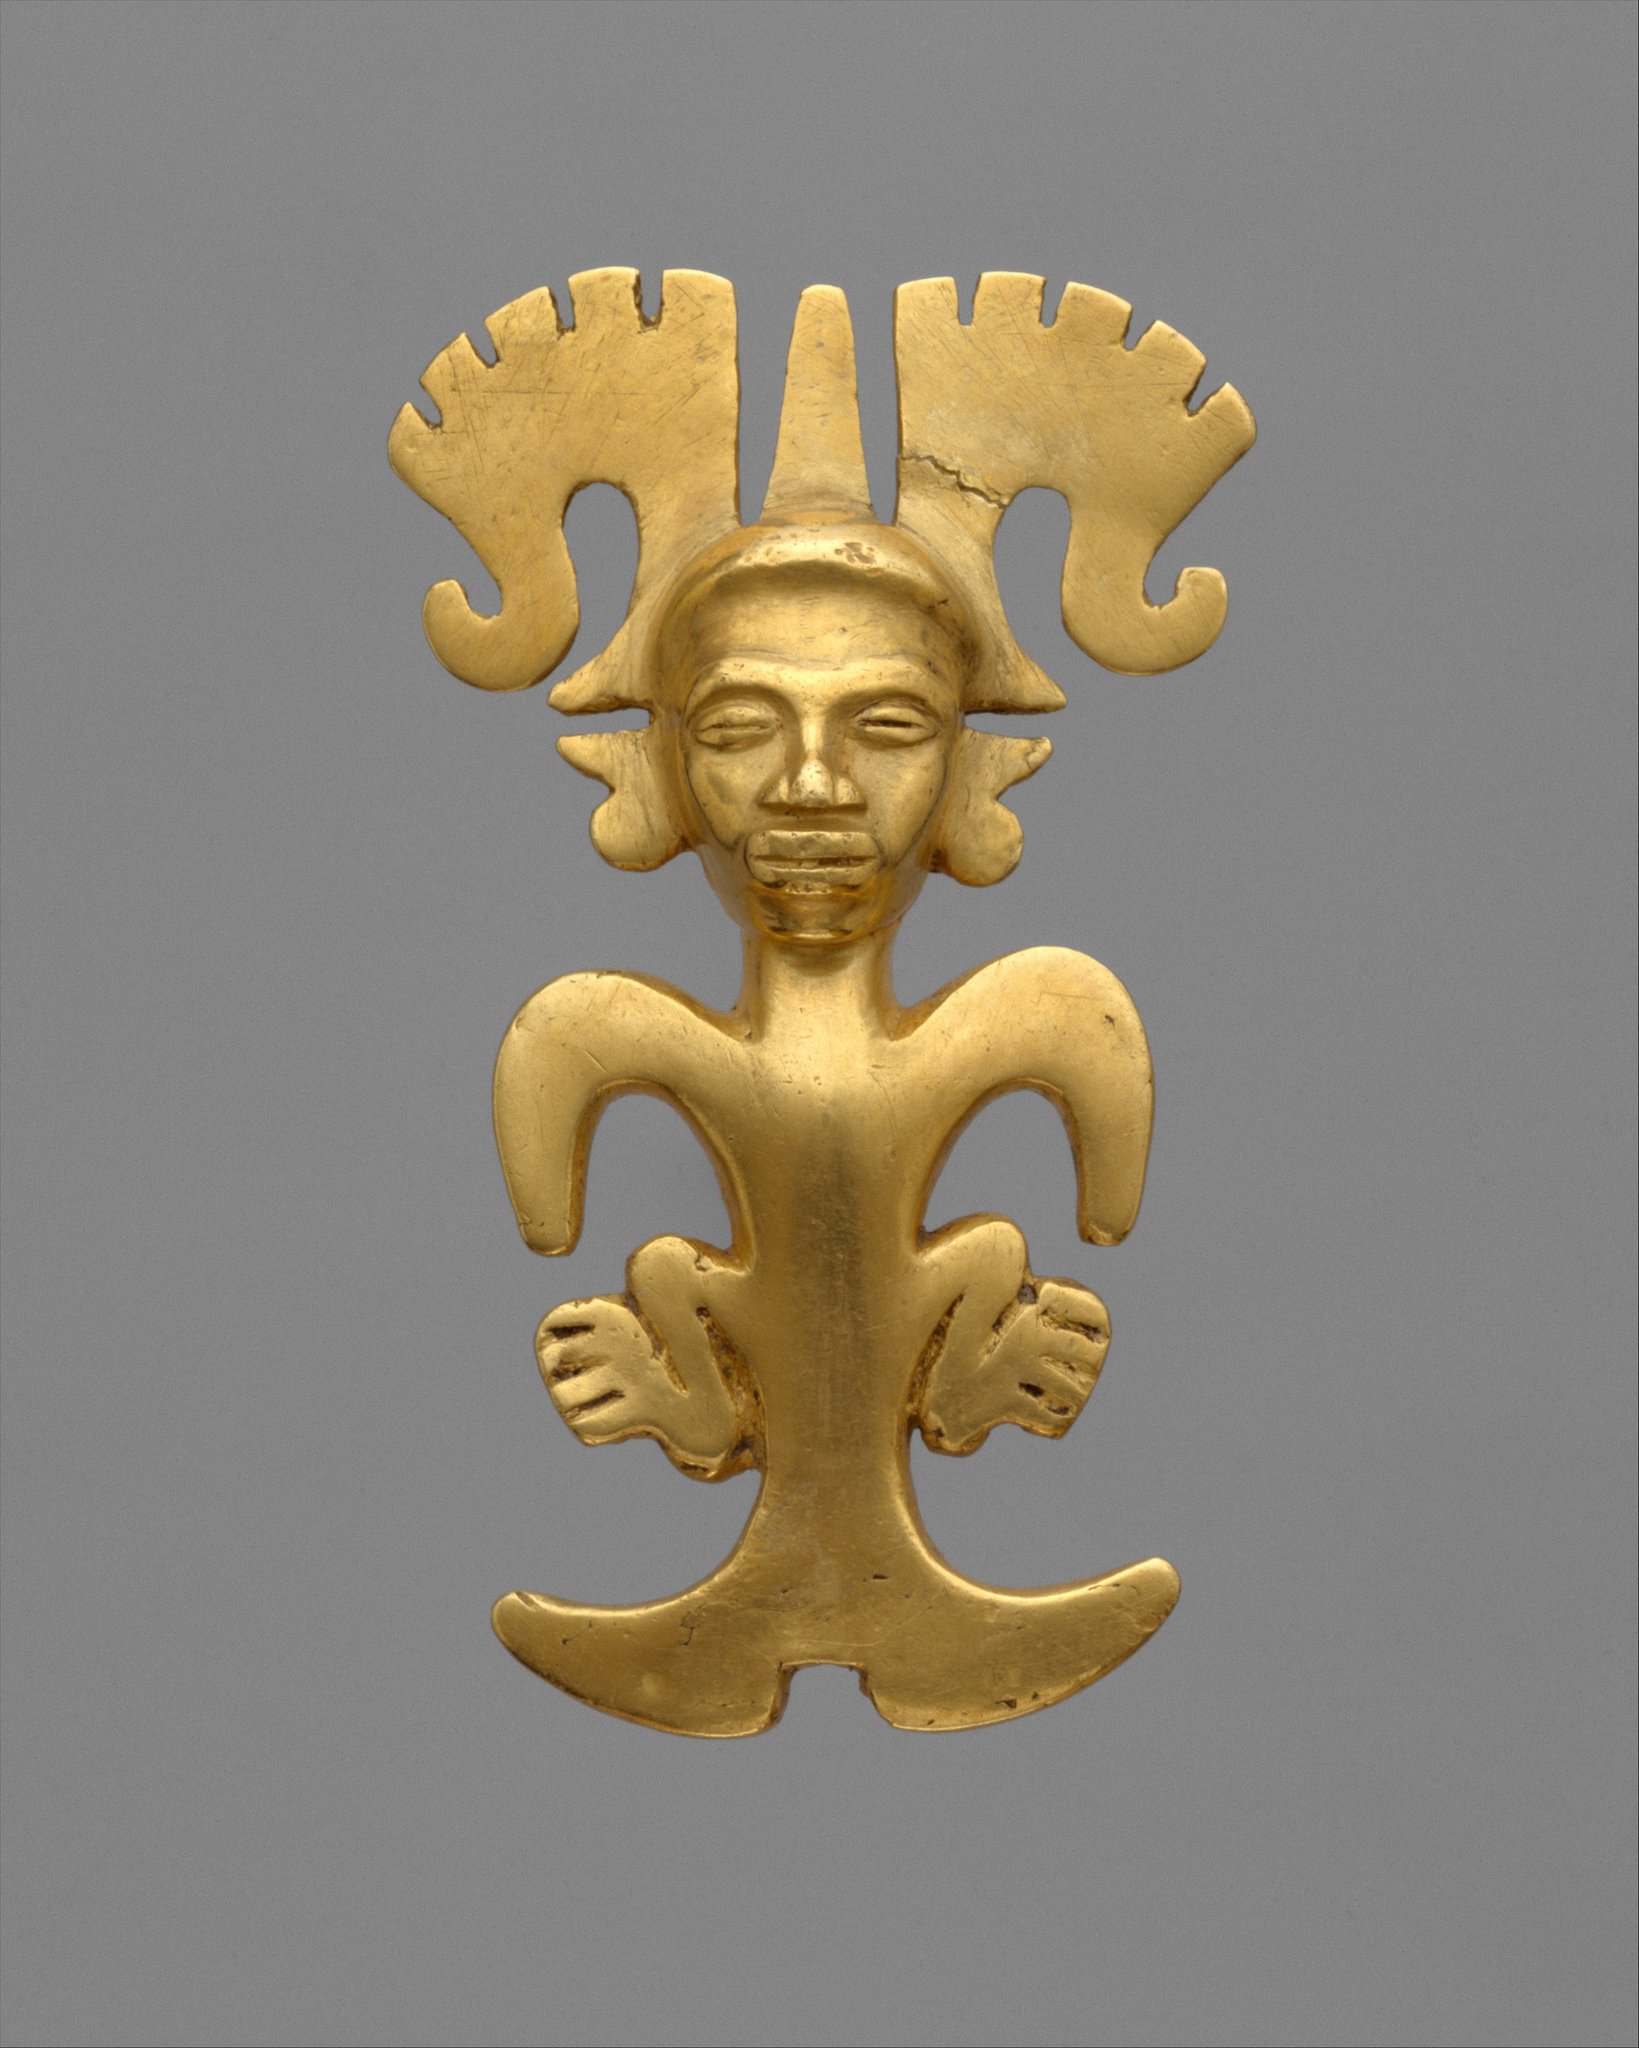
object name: pendant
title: Figure pendant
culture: international style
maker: international or initial style artist(s)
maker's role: artist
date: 400-900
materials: gold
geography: panama